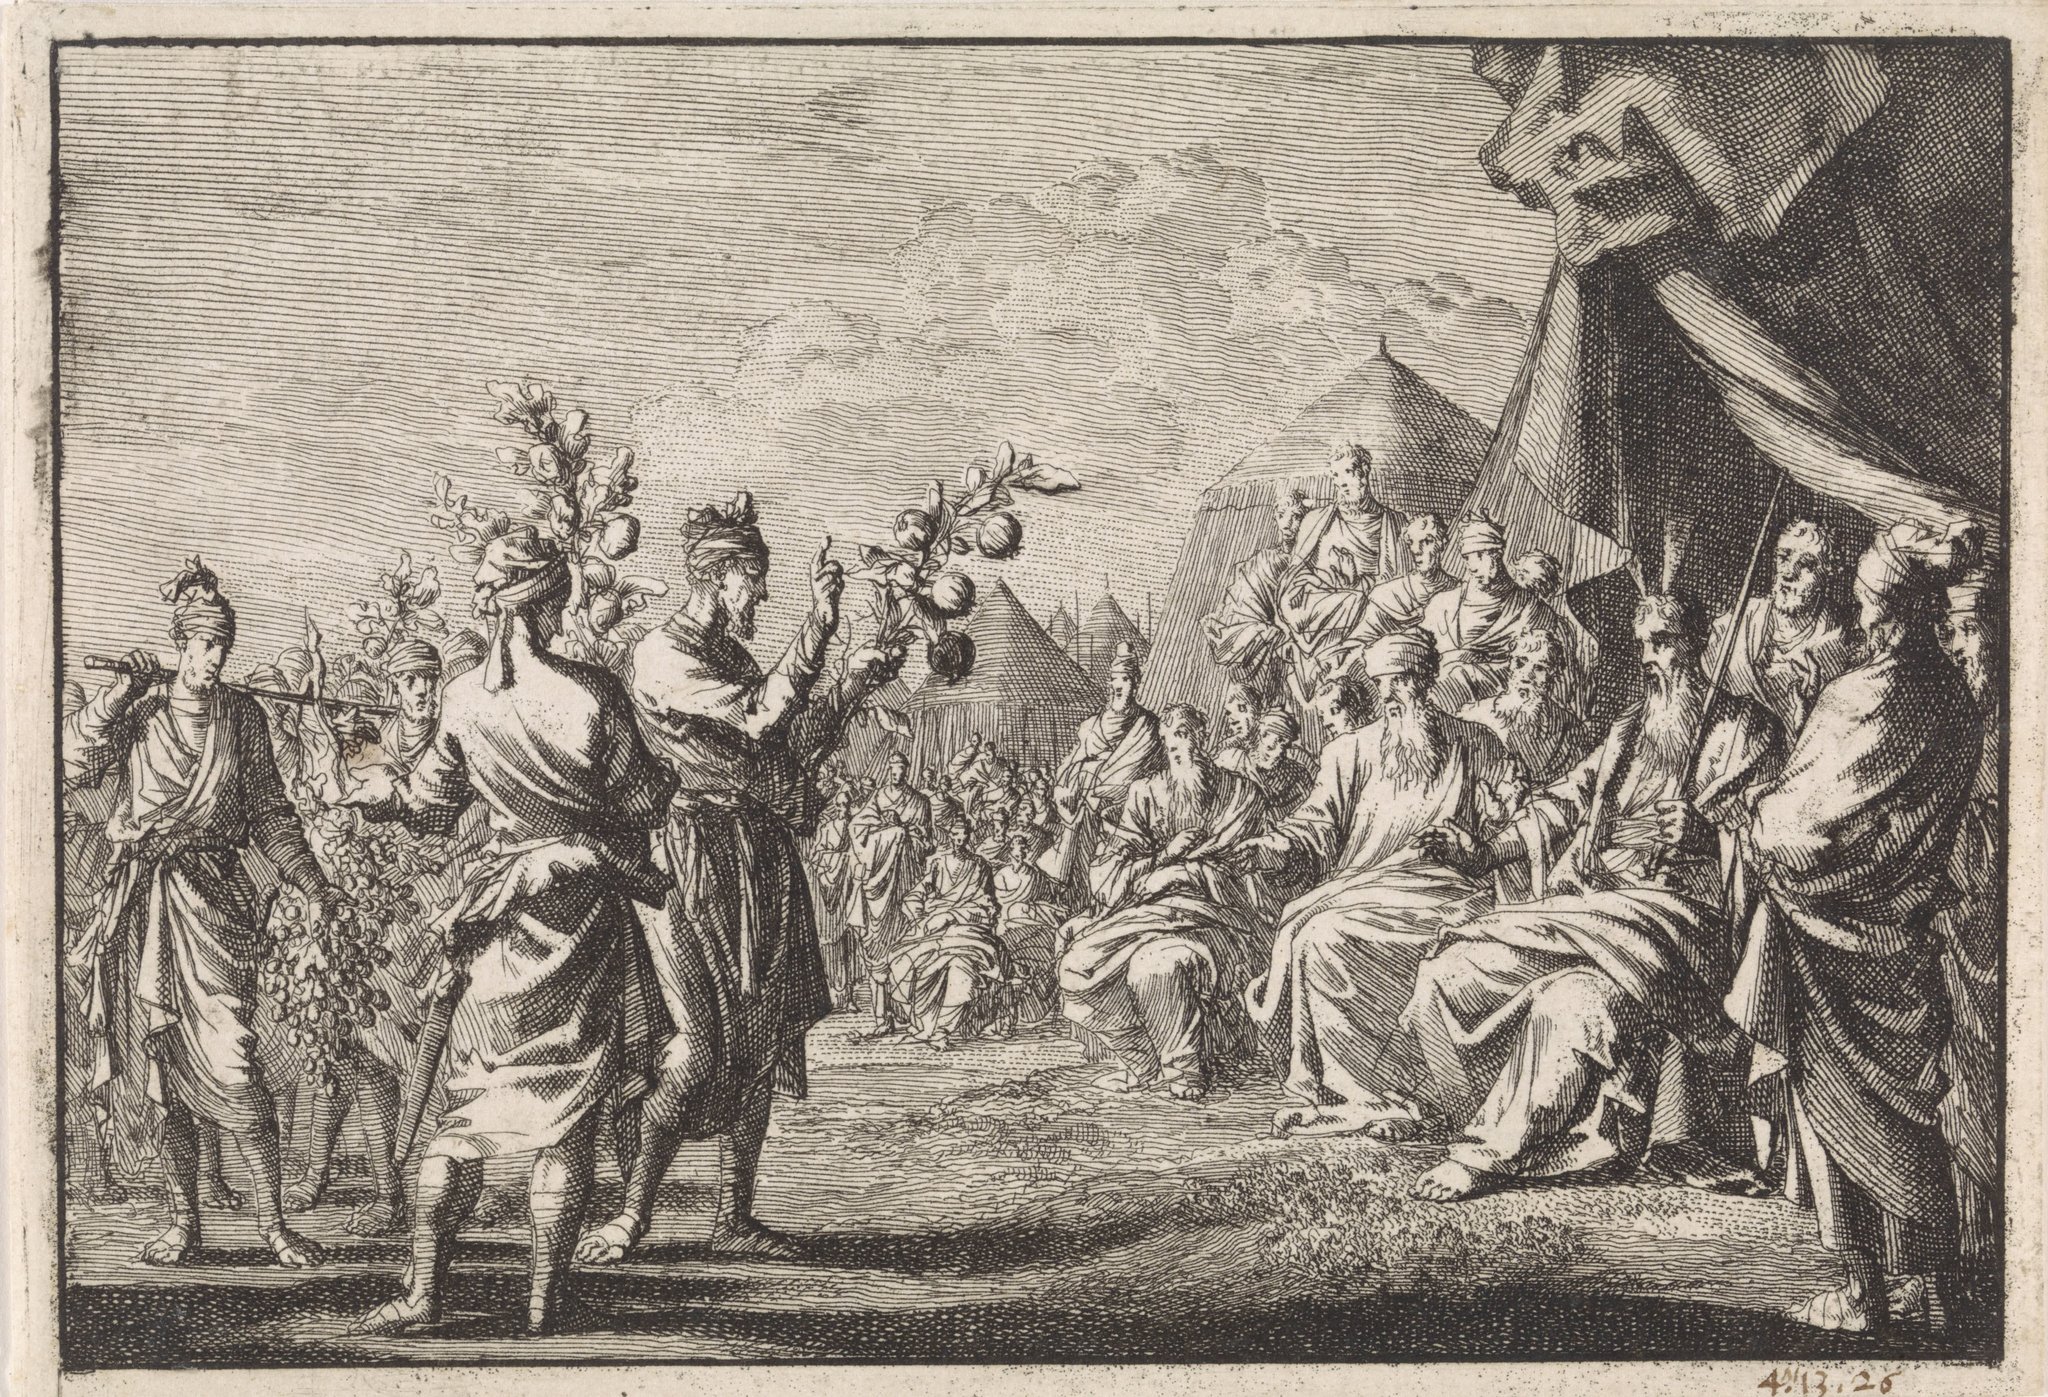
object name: print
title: Terugkeer van de verkenners uit Kanaän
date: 1703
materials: paper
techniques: etching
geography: amsterdam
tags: the spies take away some of the fruits of canaan and return, usually carrying a large bunch of grapes on a pole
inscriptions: collector's mark: Lugt 2228, number: ‘4.M.13.26’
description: Proefdruk van een boekillustratie voor David Martin. Historie des Ouden en Nieuwen Testaments. Amsterdam, Pieter Mortier, 1703. Deel I. De boekillustraties voor de Mortierbijbel hebben verschillende staten en kopieën, waarbij de chronologische volgorde moeilijk te achterhalen valt. Als boekillustraties werden ze bovendien herhaaldelijk opnieuw gebruikt voor andere boekwerken.